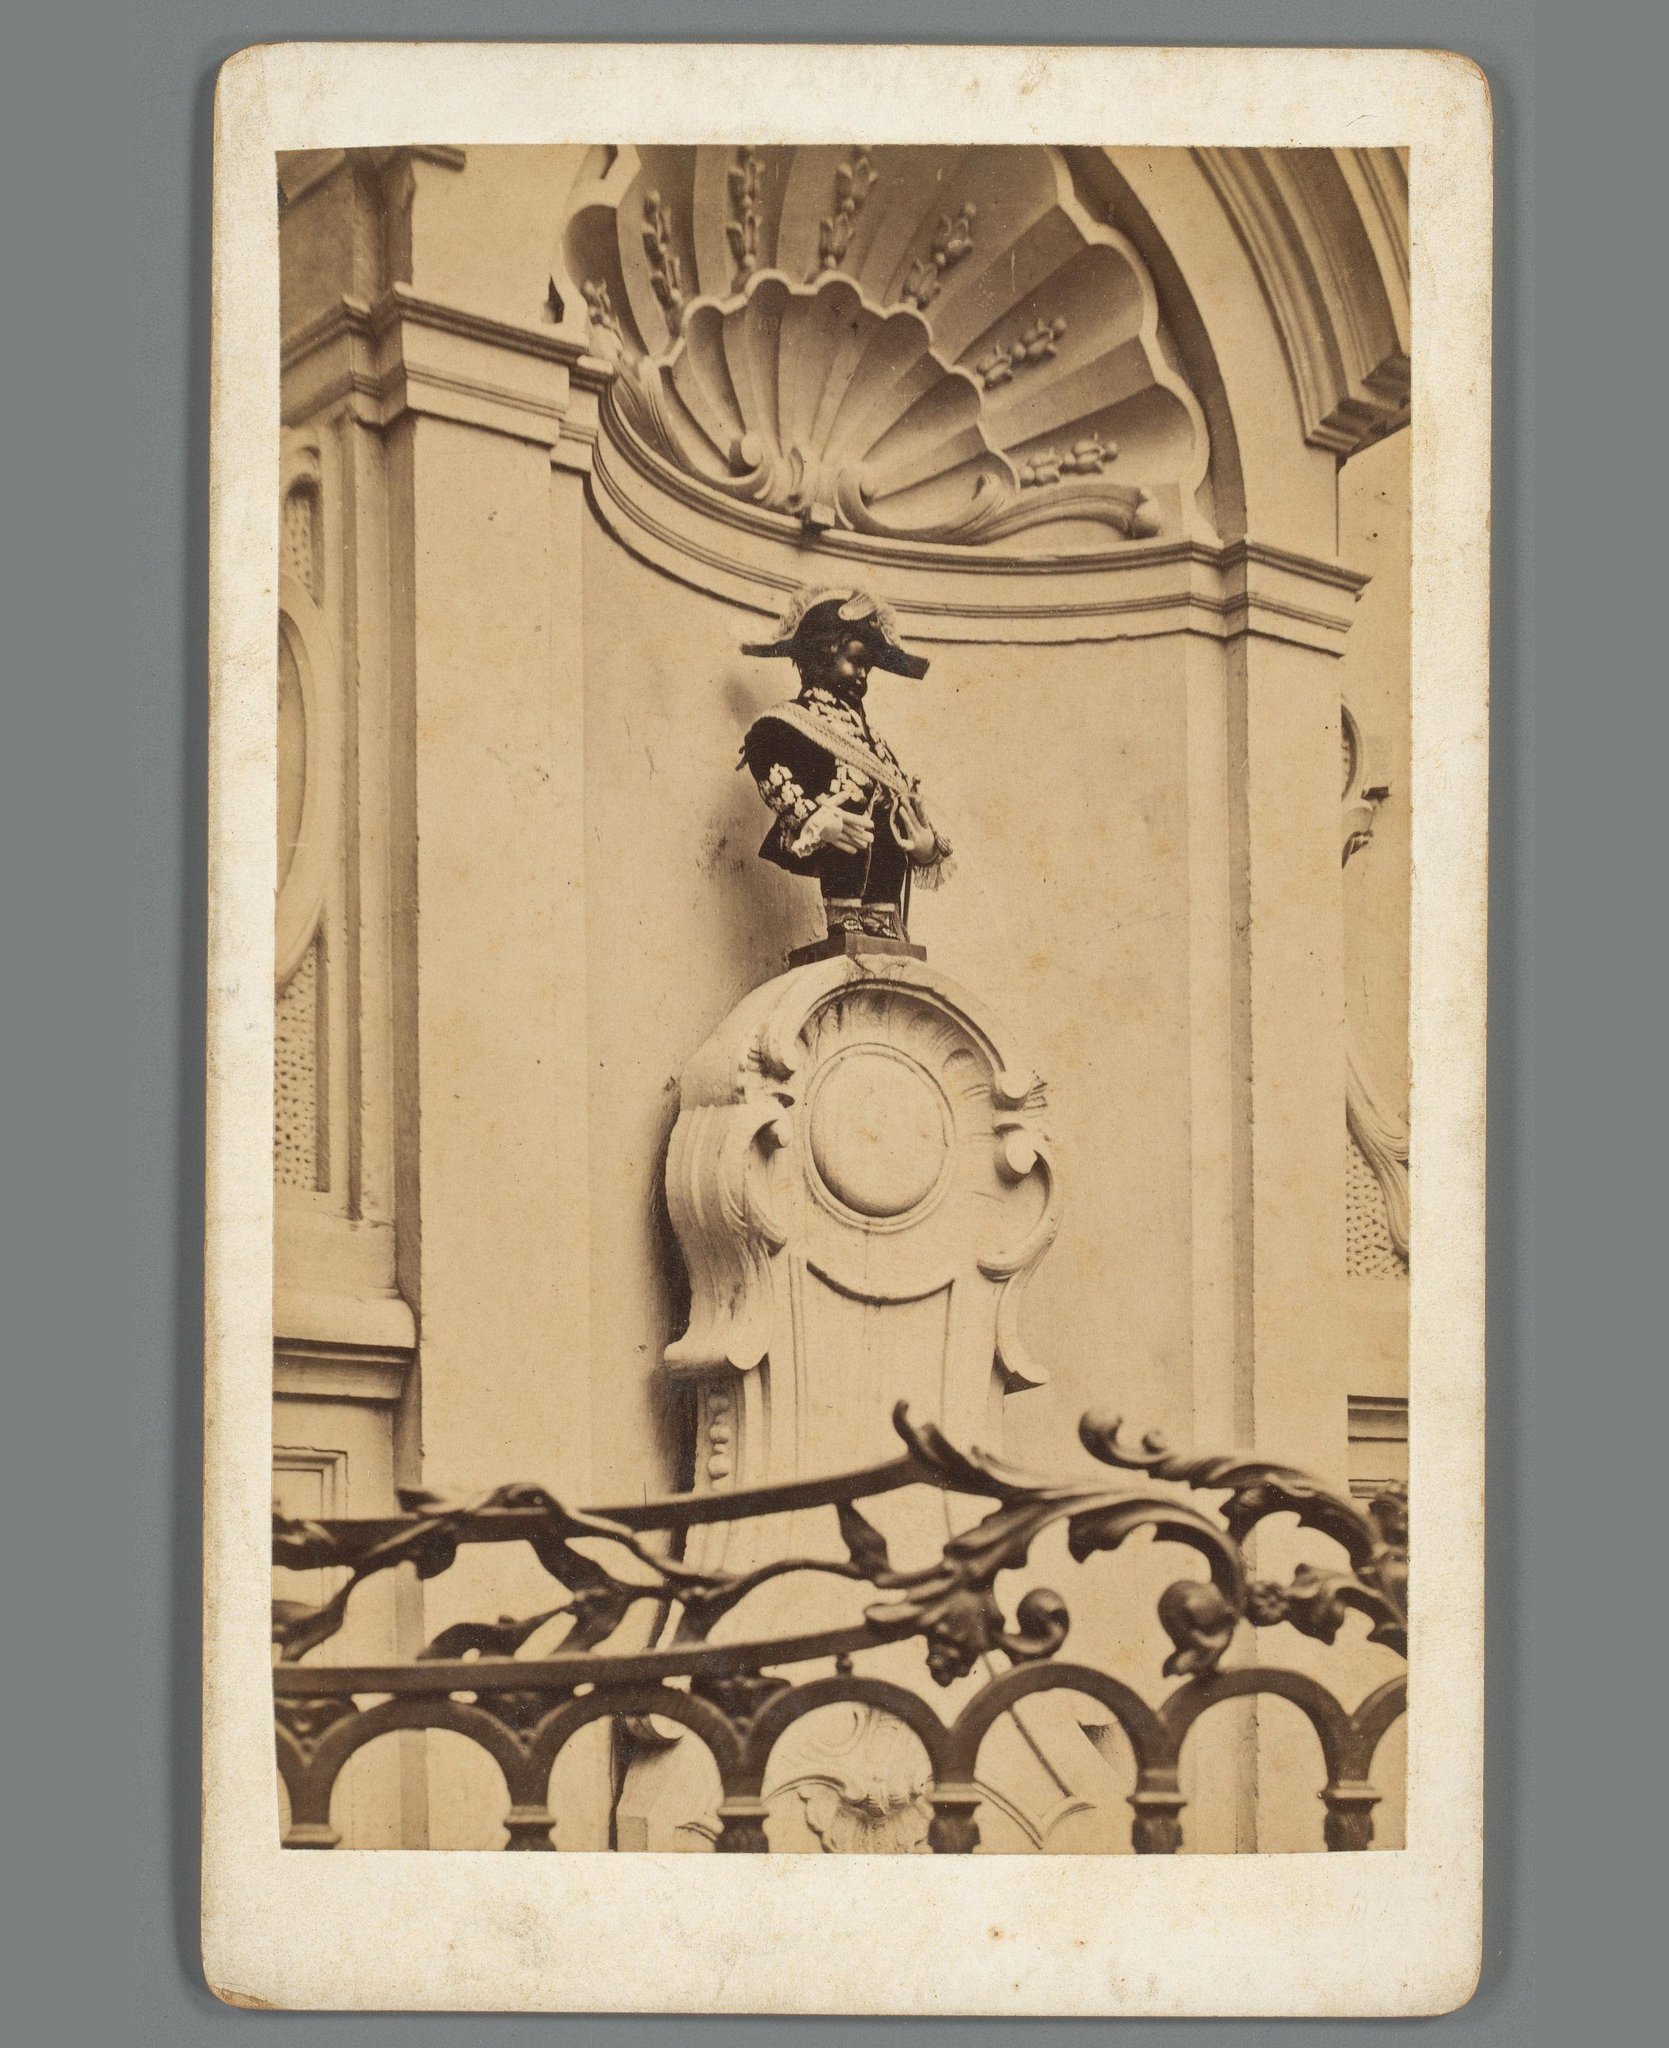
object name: cabinet photograph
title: Bruxelles: Manneken-Pis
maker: Anonymous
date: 1870-1890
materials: cardboard, paper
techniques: albumen print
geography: brussels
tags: piece of sculpture, reproduction of a piece of sculpture, ornamental fountain, (military) uniforms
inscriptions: collector's mark: ‘Vosmaer’